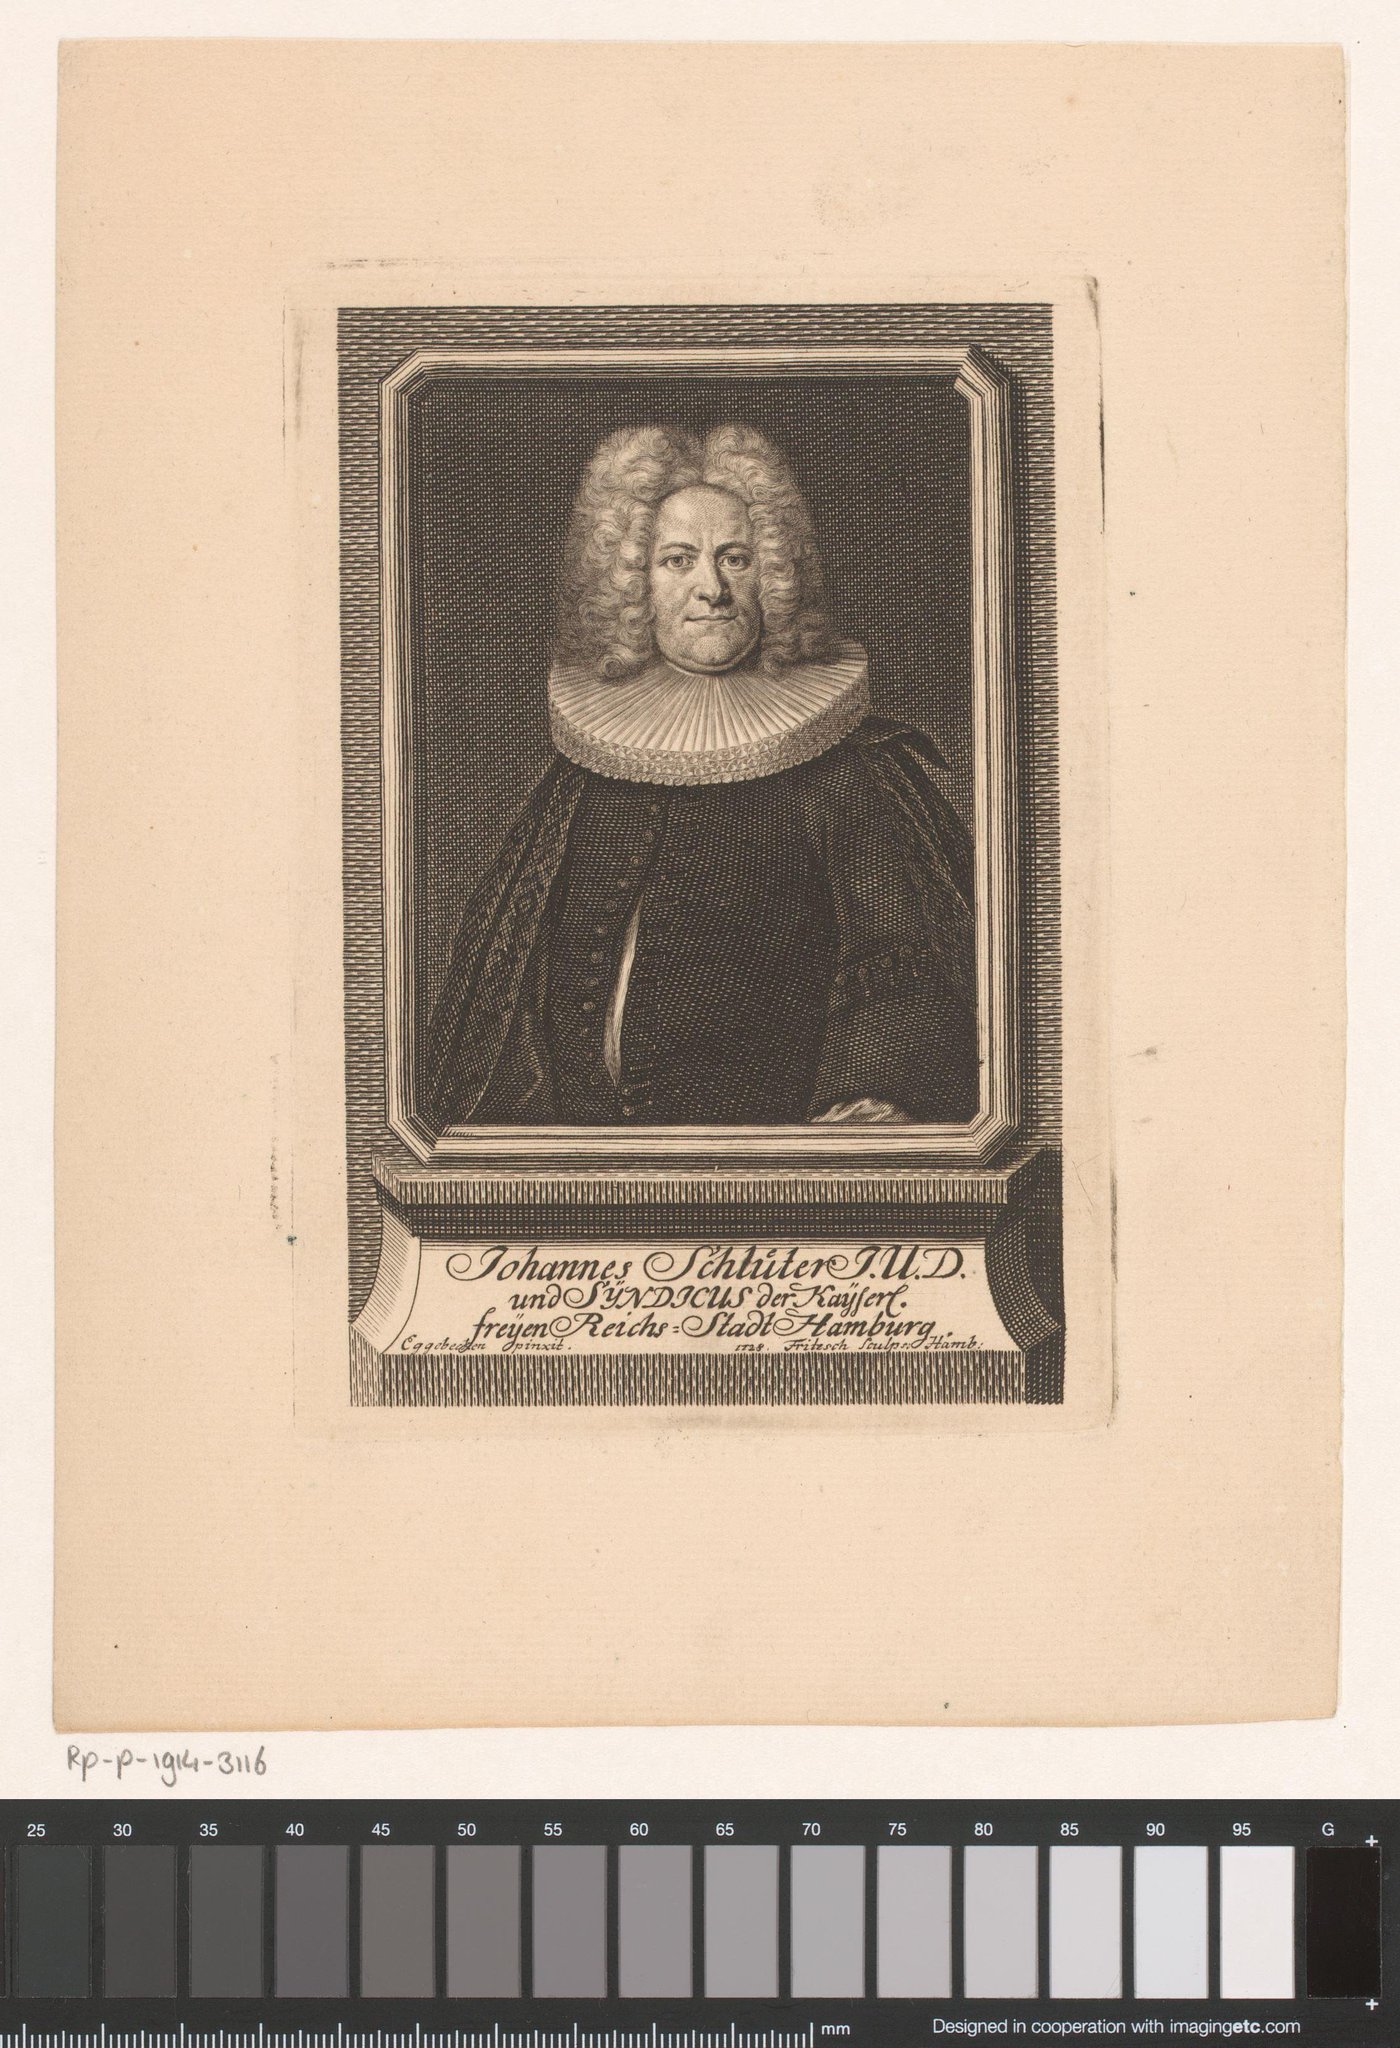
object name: print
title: Portret van Johann Schlüter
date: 1728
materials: paper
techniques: engraving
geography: hamburg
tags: historical persons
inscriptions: collector's mark: Lugt 2228